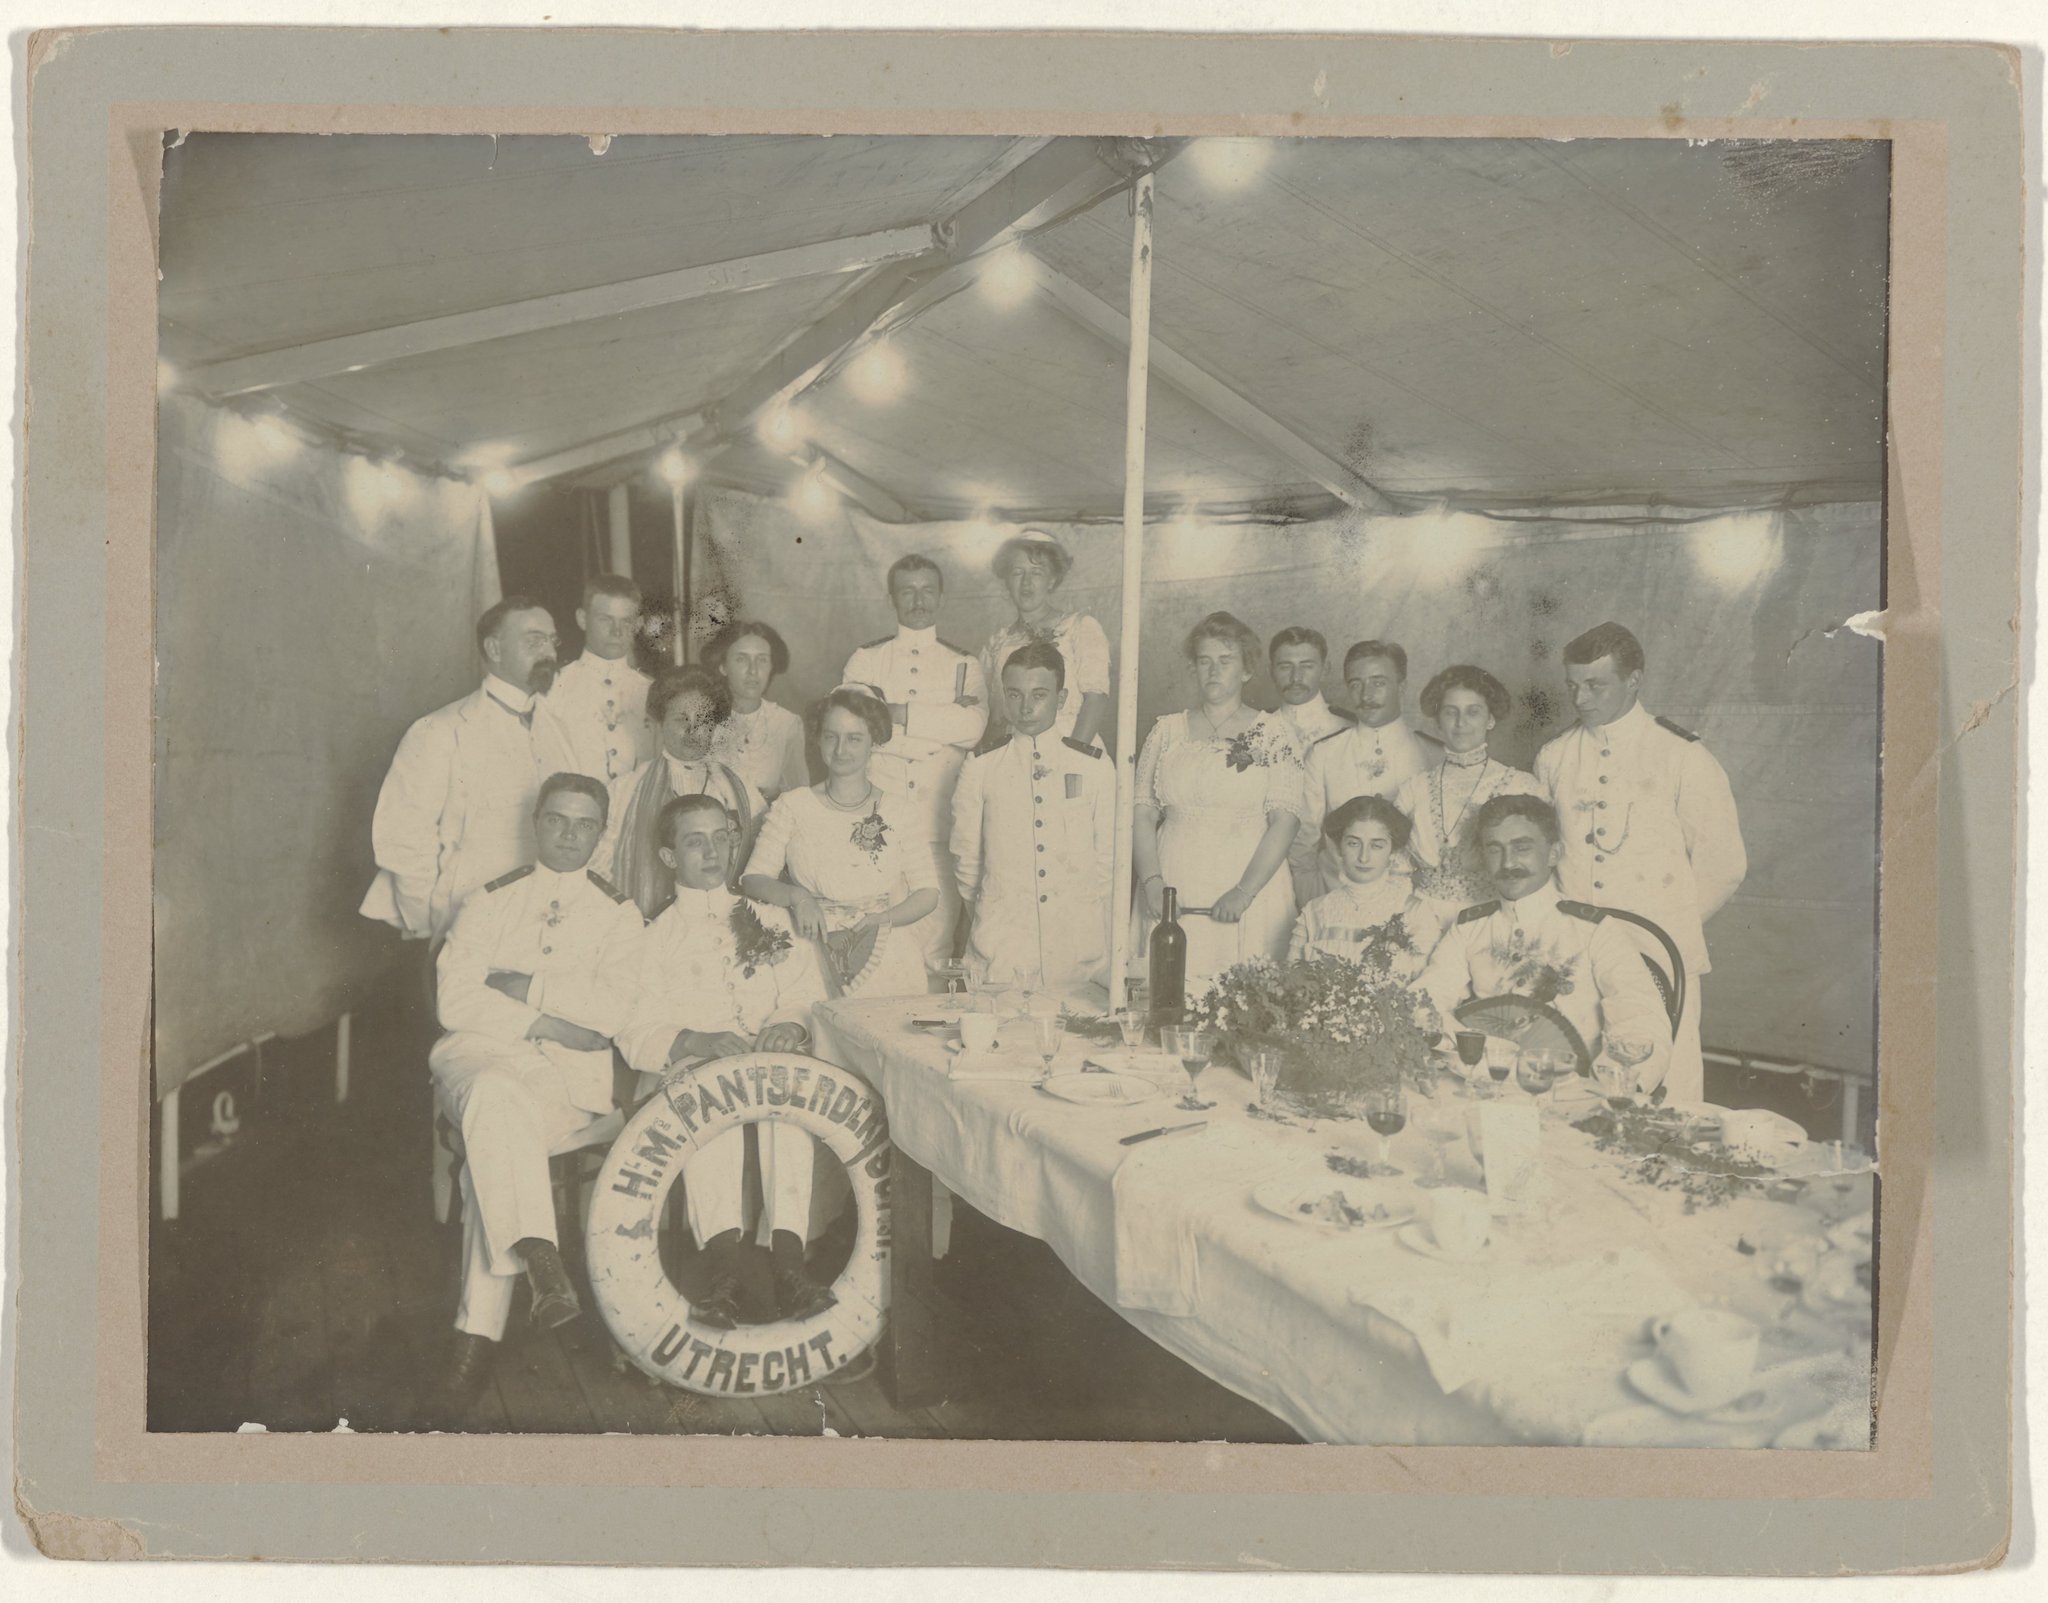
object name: photograph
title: Feest aan boord van een schip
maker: Anonymous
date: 1908-1915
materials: cardboard, photographic support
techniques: photography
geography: suriname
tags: navy (+ motor ships), private festivities, merry company, suriname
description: Gezelschap jonge mannen en vrouwen tijdens een feest aan boord van H.M. Pantserdekschip 'Utrecht', vermoedelijk tijdens Nieuwjaar. Onderdeel van een groep foto's van de familie Boom-Gonggrijp in Suriname.